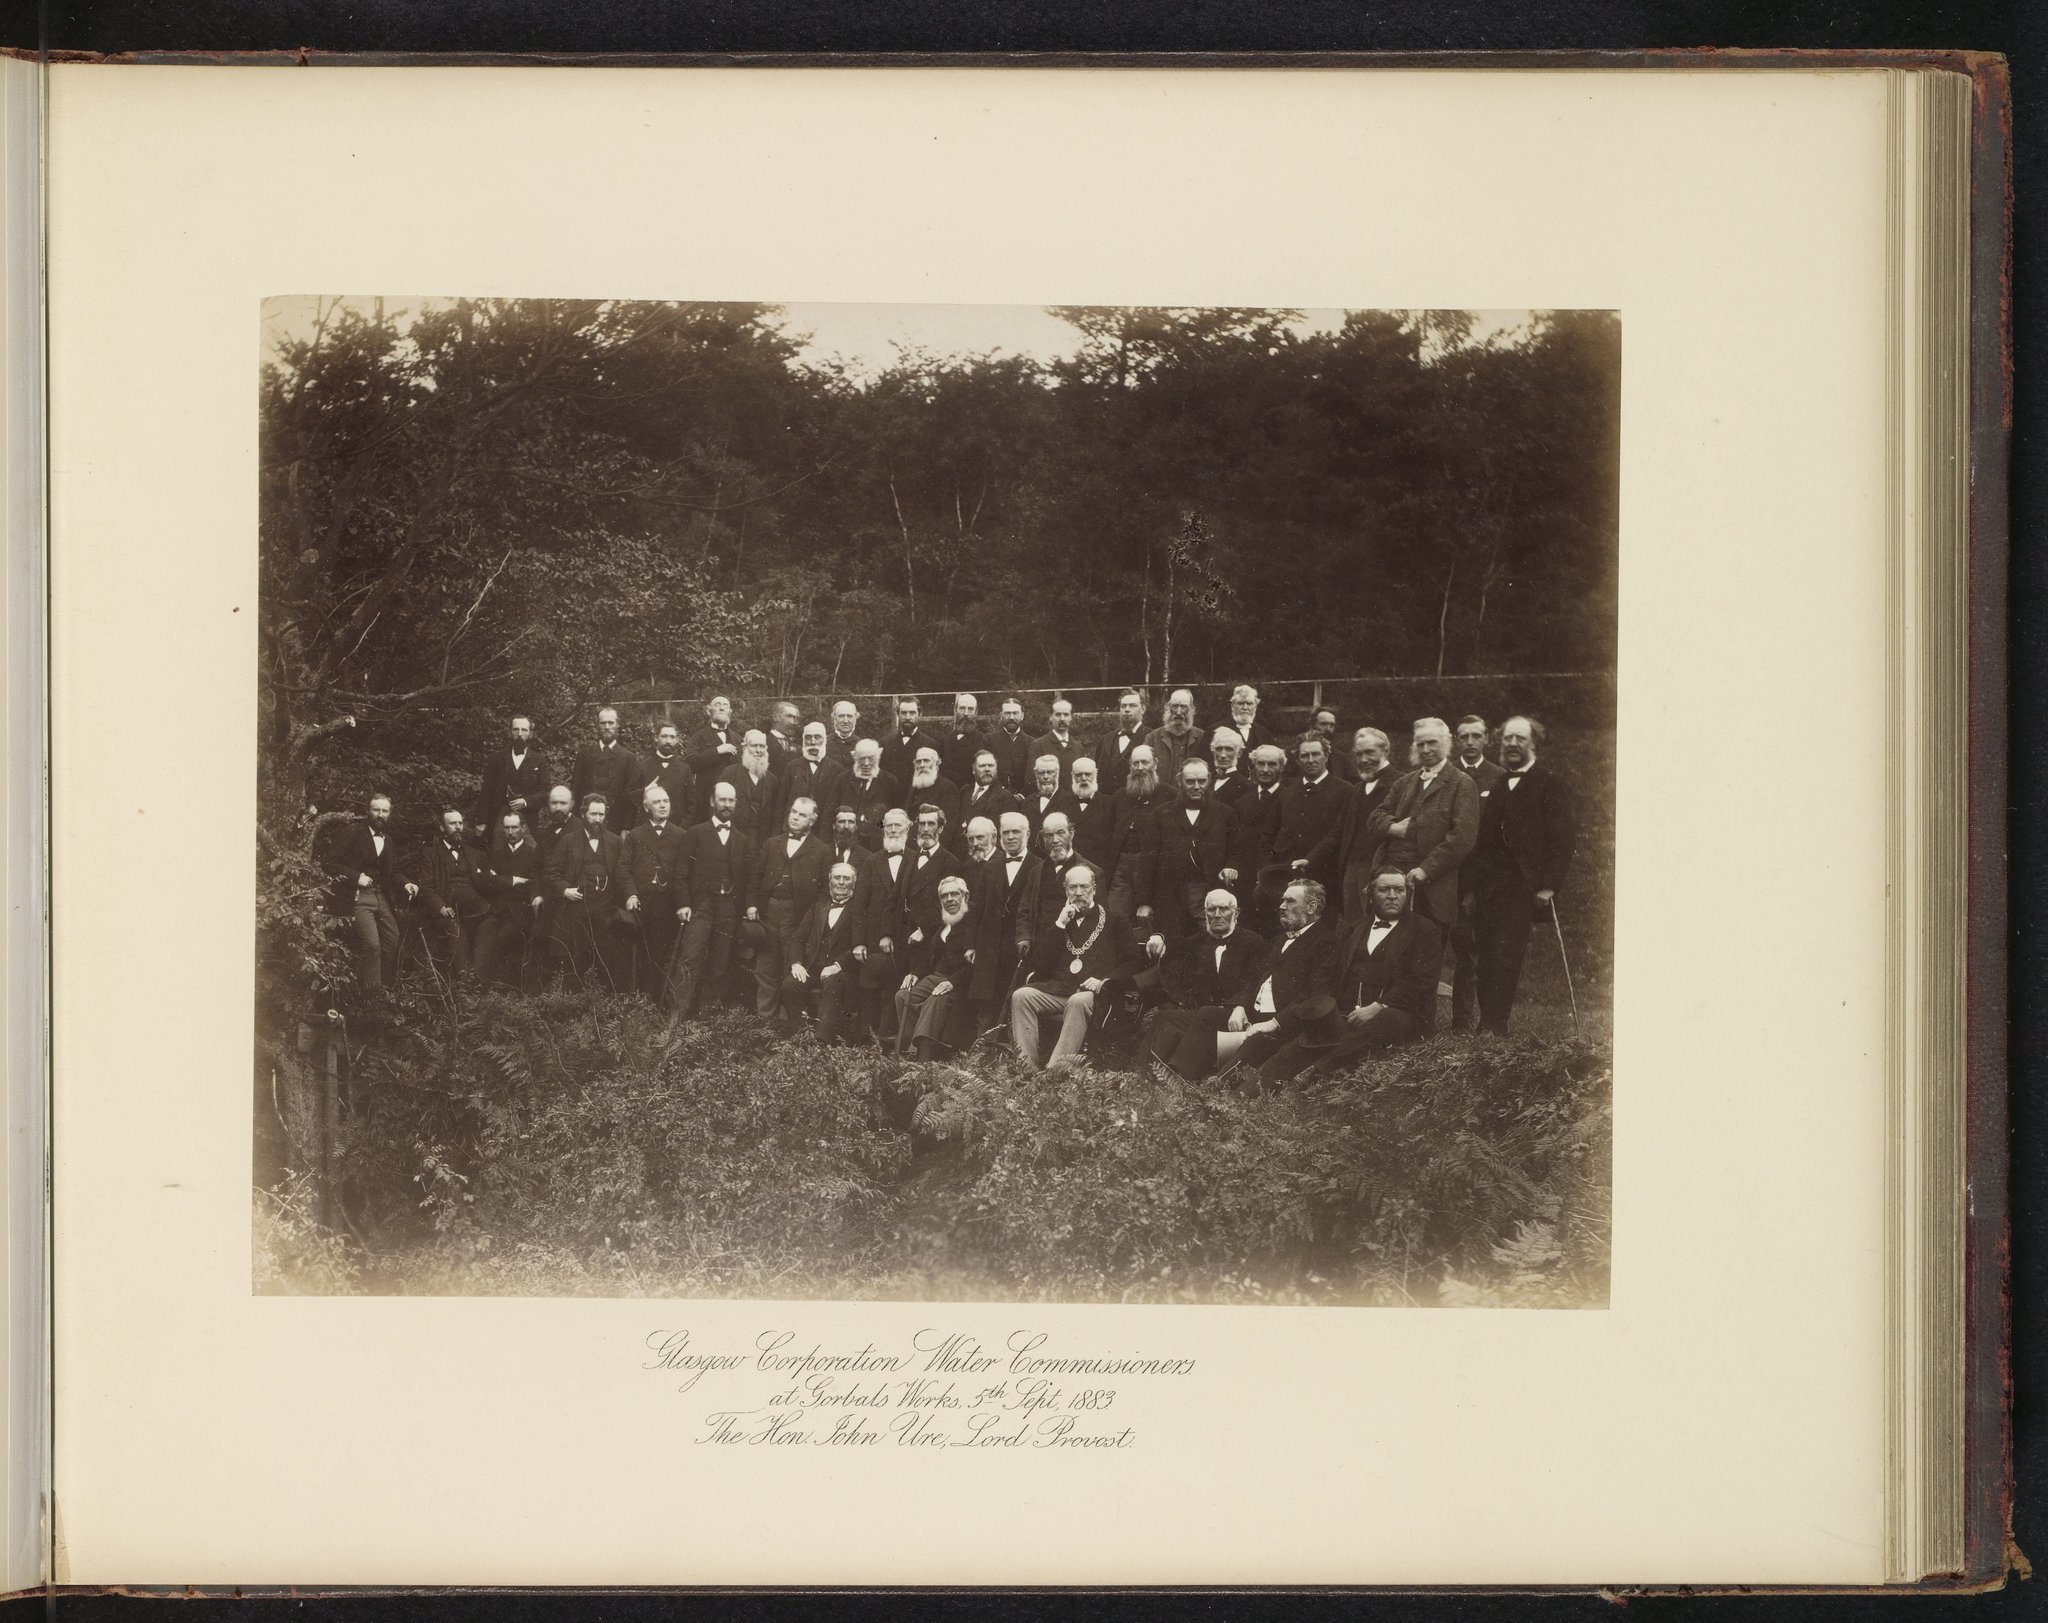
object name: photograph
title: Glasgow Corporation Water Commissioners at Gorbals Works 5th Sept. 1883. The Hon. John Ure, Lord Provost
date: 1883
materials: photographic support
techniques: albumen print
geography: scottish highlands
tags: committee members, board members, anonymous historical persons portrayed in a group, in a group-portrait